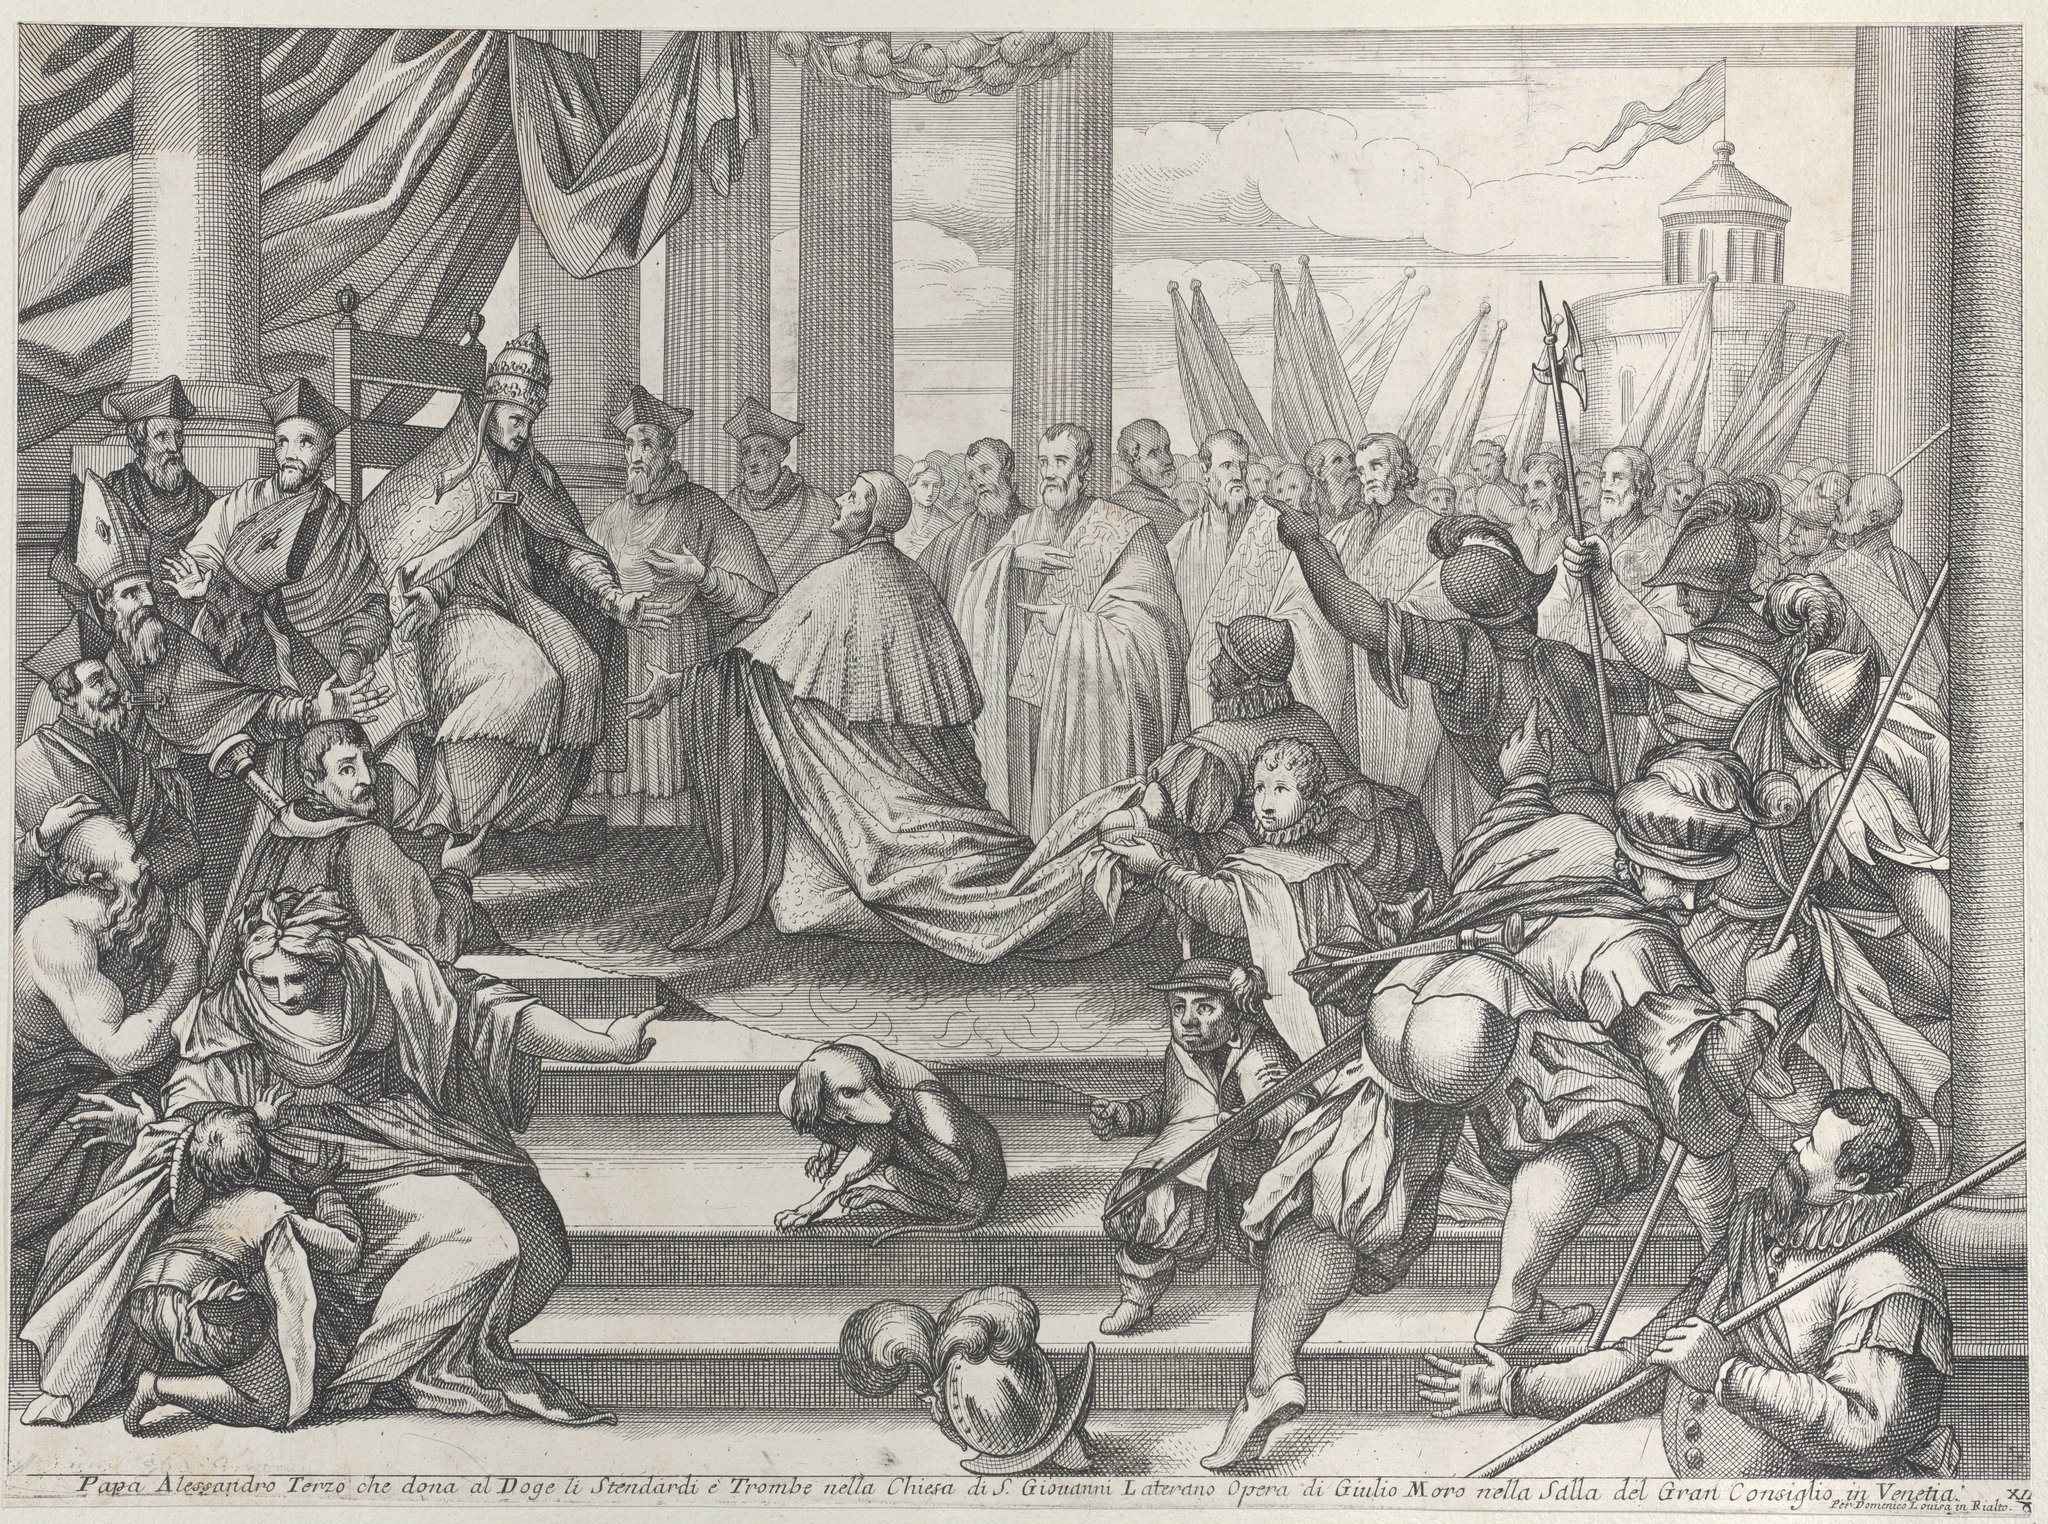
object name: print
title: Pope Alexander III presents Doge Ziani with standards and bugles after his defeat of Holy Roman Emperor Frederick I Barbarossa, from "Il gran Teatro di Venezia" (The great theater of Venice)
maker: Anonymous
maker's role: artist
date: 1720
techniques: etching